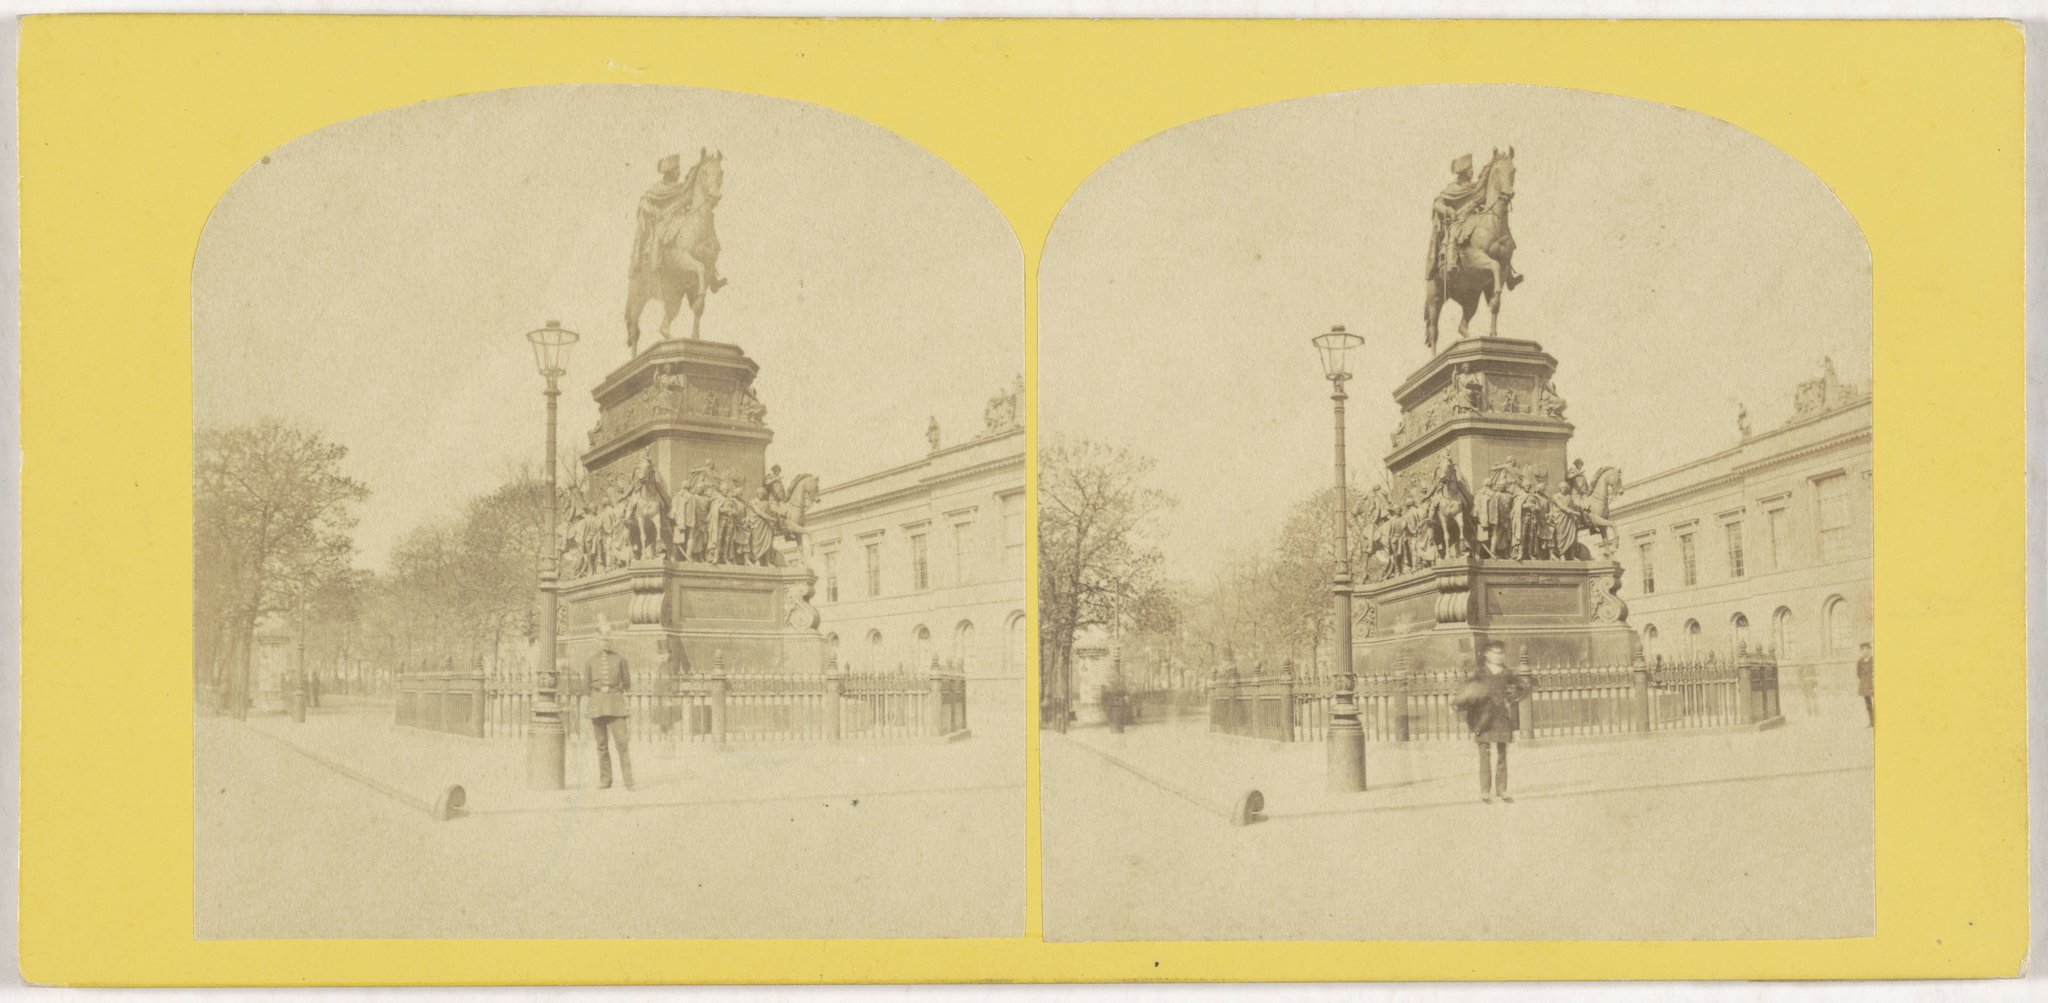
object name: stereograph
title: Ruiterstandbeeld van Frederik de Grote in Berlijn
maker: Anonymous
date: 1861-1862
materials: cardboard, paper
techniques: albumen print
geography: berlin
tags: berlin, frederick ii (king of prussia), equestrian statue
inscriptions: number: ‘No. 30.’, inscription: ‘B. 4.’